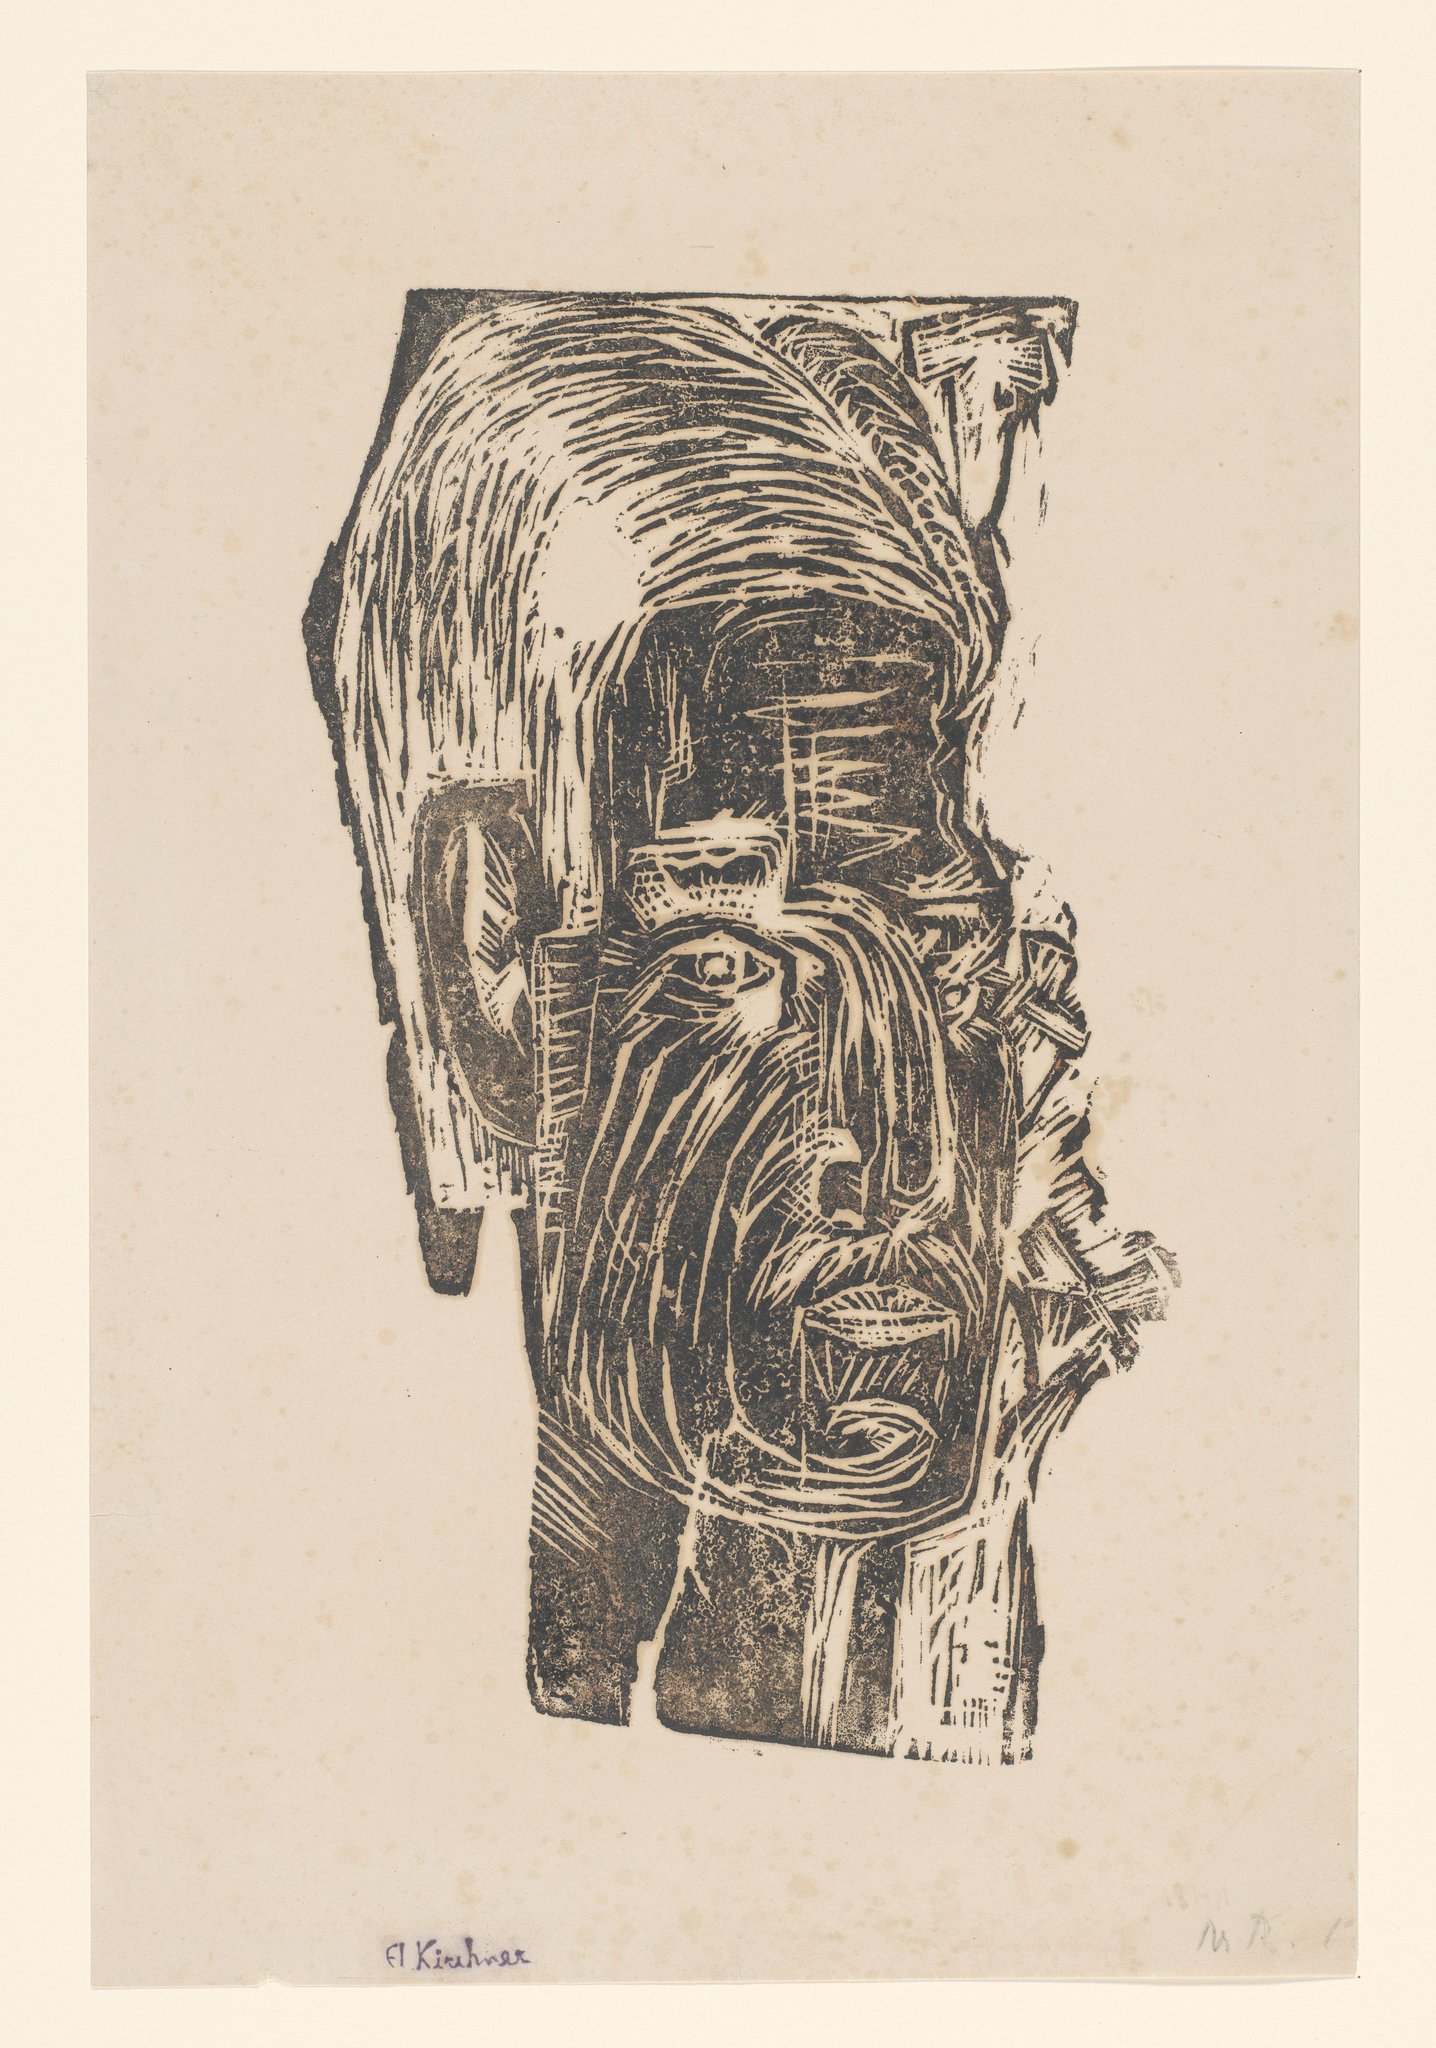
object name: print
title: Portret van een onbekende man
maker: ernst ludwig kirchner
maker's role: print maker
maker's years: 1880-1938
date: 1890-1938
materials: paper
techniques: woodcut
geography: germany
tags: anonymous historical person portrayed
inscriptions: collector's mark: Lugt 2228, collector's mark: Lugt 2760, annotation: ‘Signatuur eruit gehaald bij het schoon maken v.d. prent 1951, later weer ingezet.’